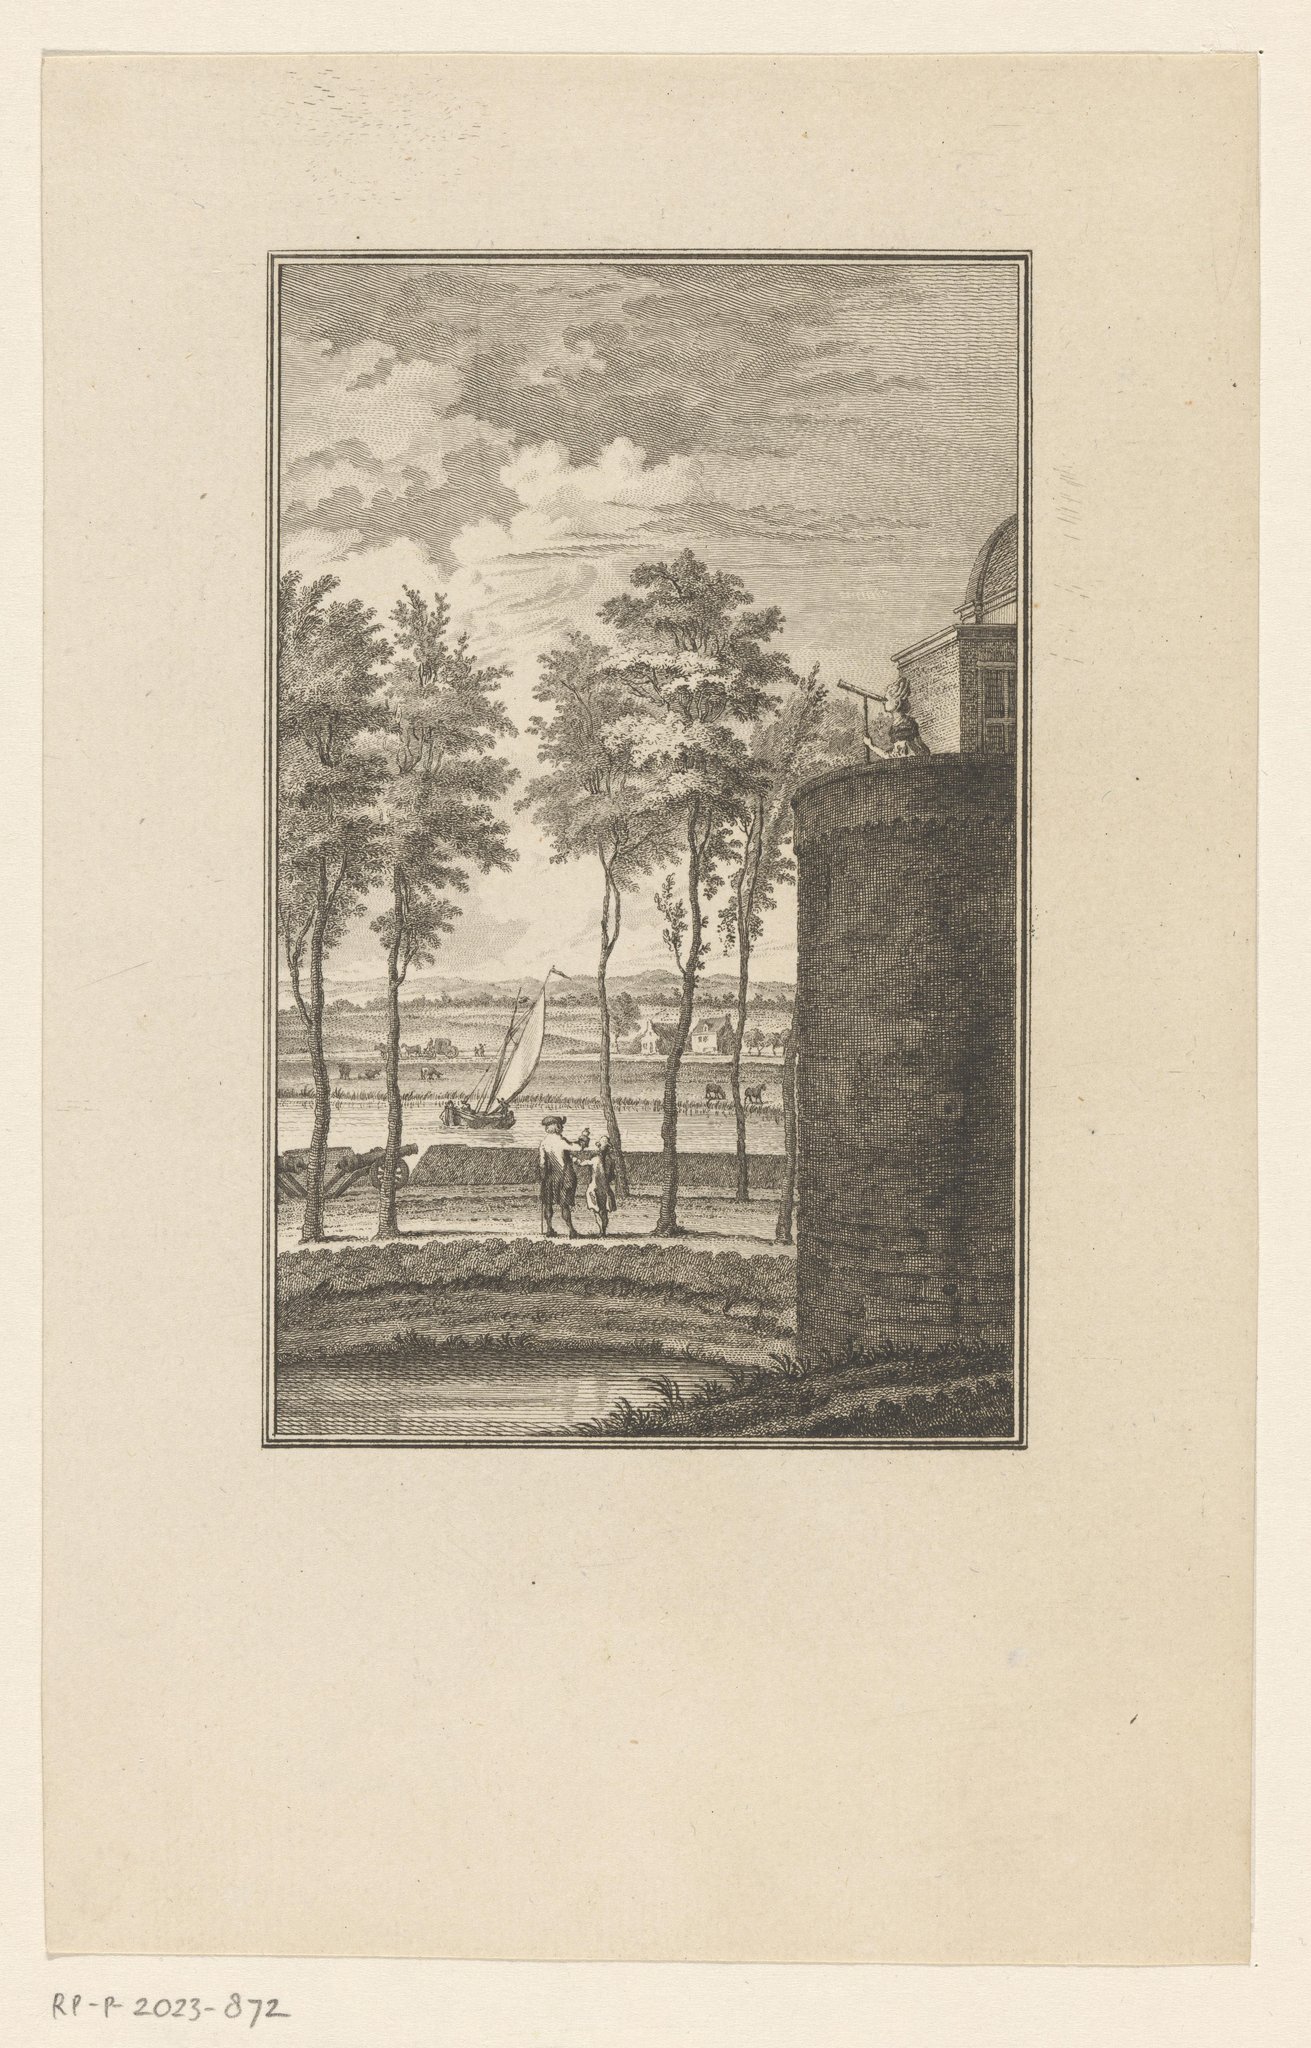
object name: print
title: Vrouw op een toren bij de wallen van Zutphen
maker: reinier vinkeles (i)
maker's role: draughtsman, print maker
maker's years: 1741-1816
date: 1786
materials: paper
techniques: engraving, etching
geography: amsterdam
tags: sailing-ship, sailing-boat, river, towers ~ fortified city, landscape with bridge, viaduct or aqueduct, landscape with tower or castle, fortifications, military engineering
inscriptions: collector's mark: Lugt 240, collector's mark: Lugt 2228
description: Een vrouw op een toren kijkt door een verrekijker. Aan de oever van de rivier de IJssel de wallen van Zutphen, met twee figuren in gesprek bij een kanon.